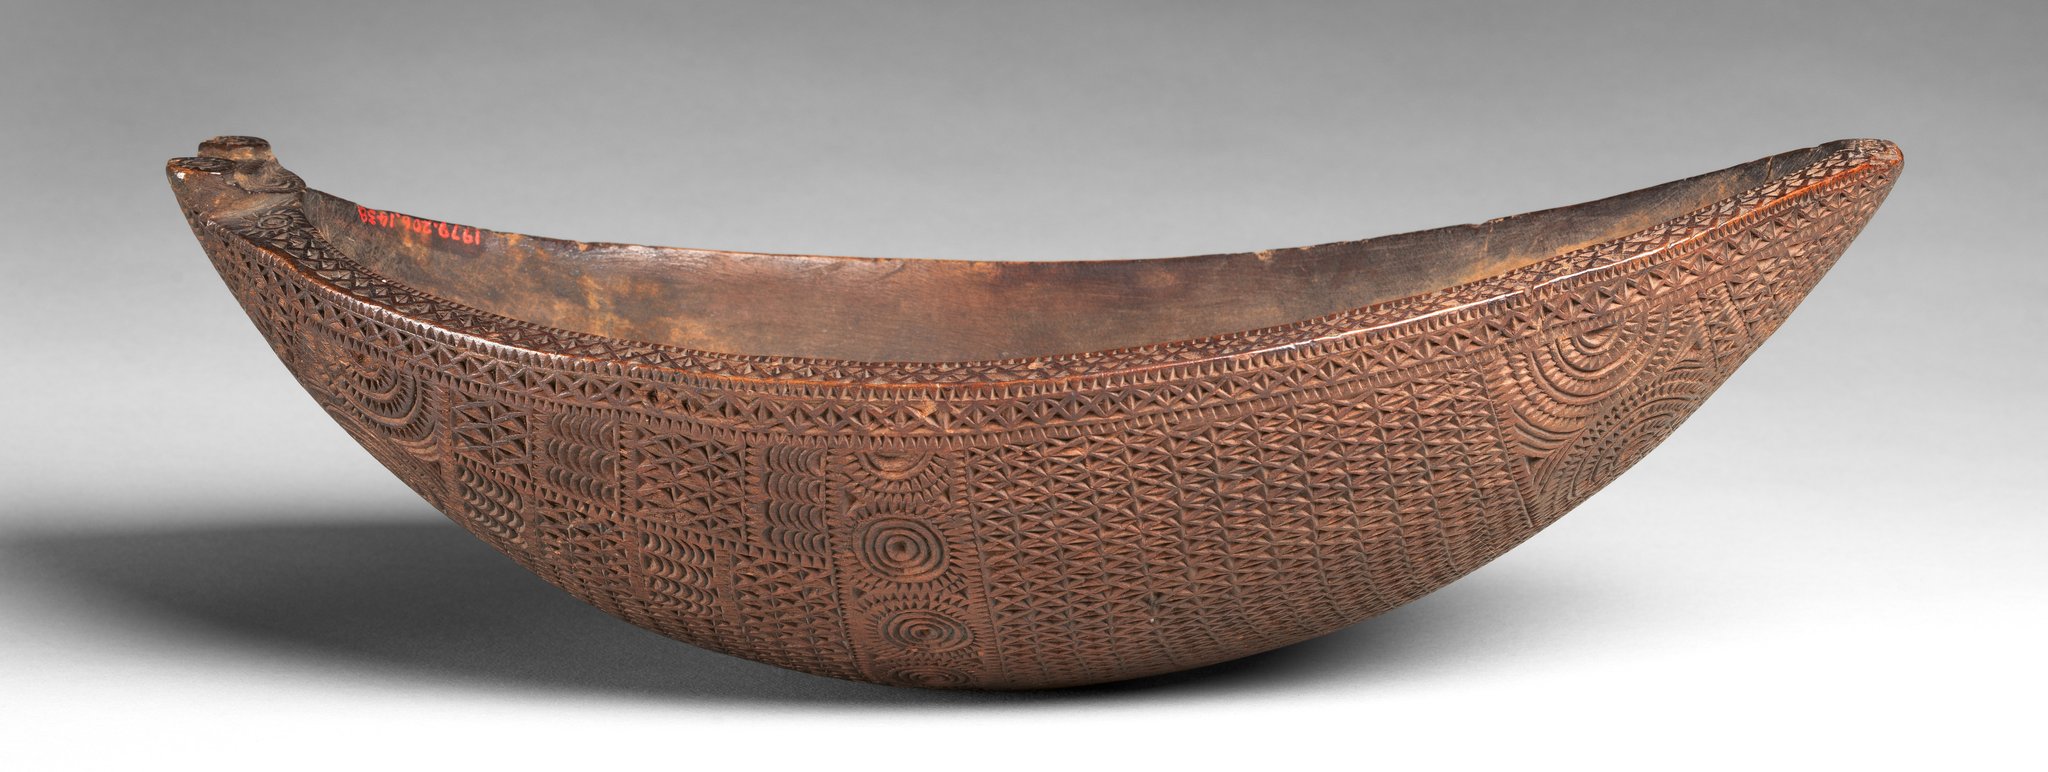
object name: bowl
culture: austral islanders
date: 1820-1840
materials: wood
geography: french polynesia